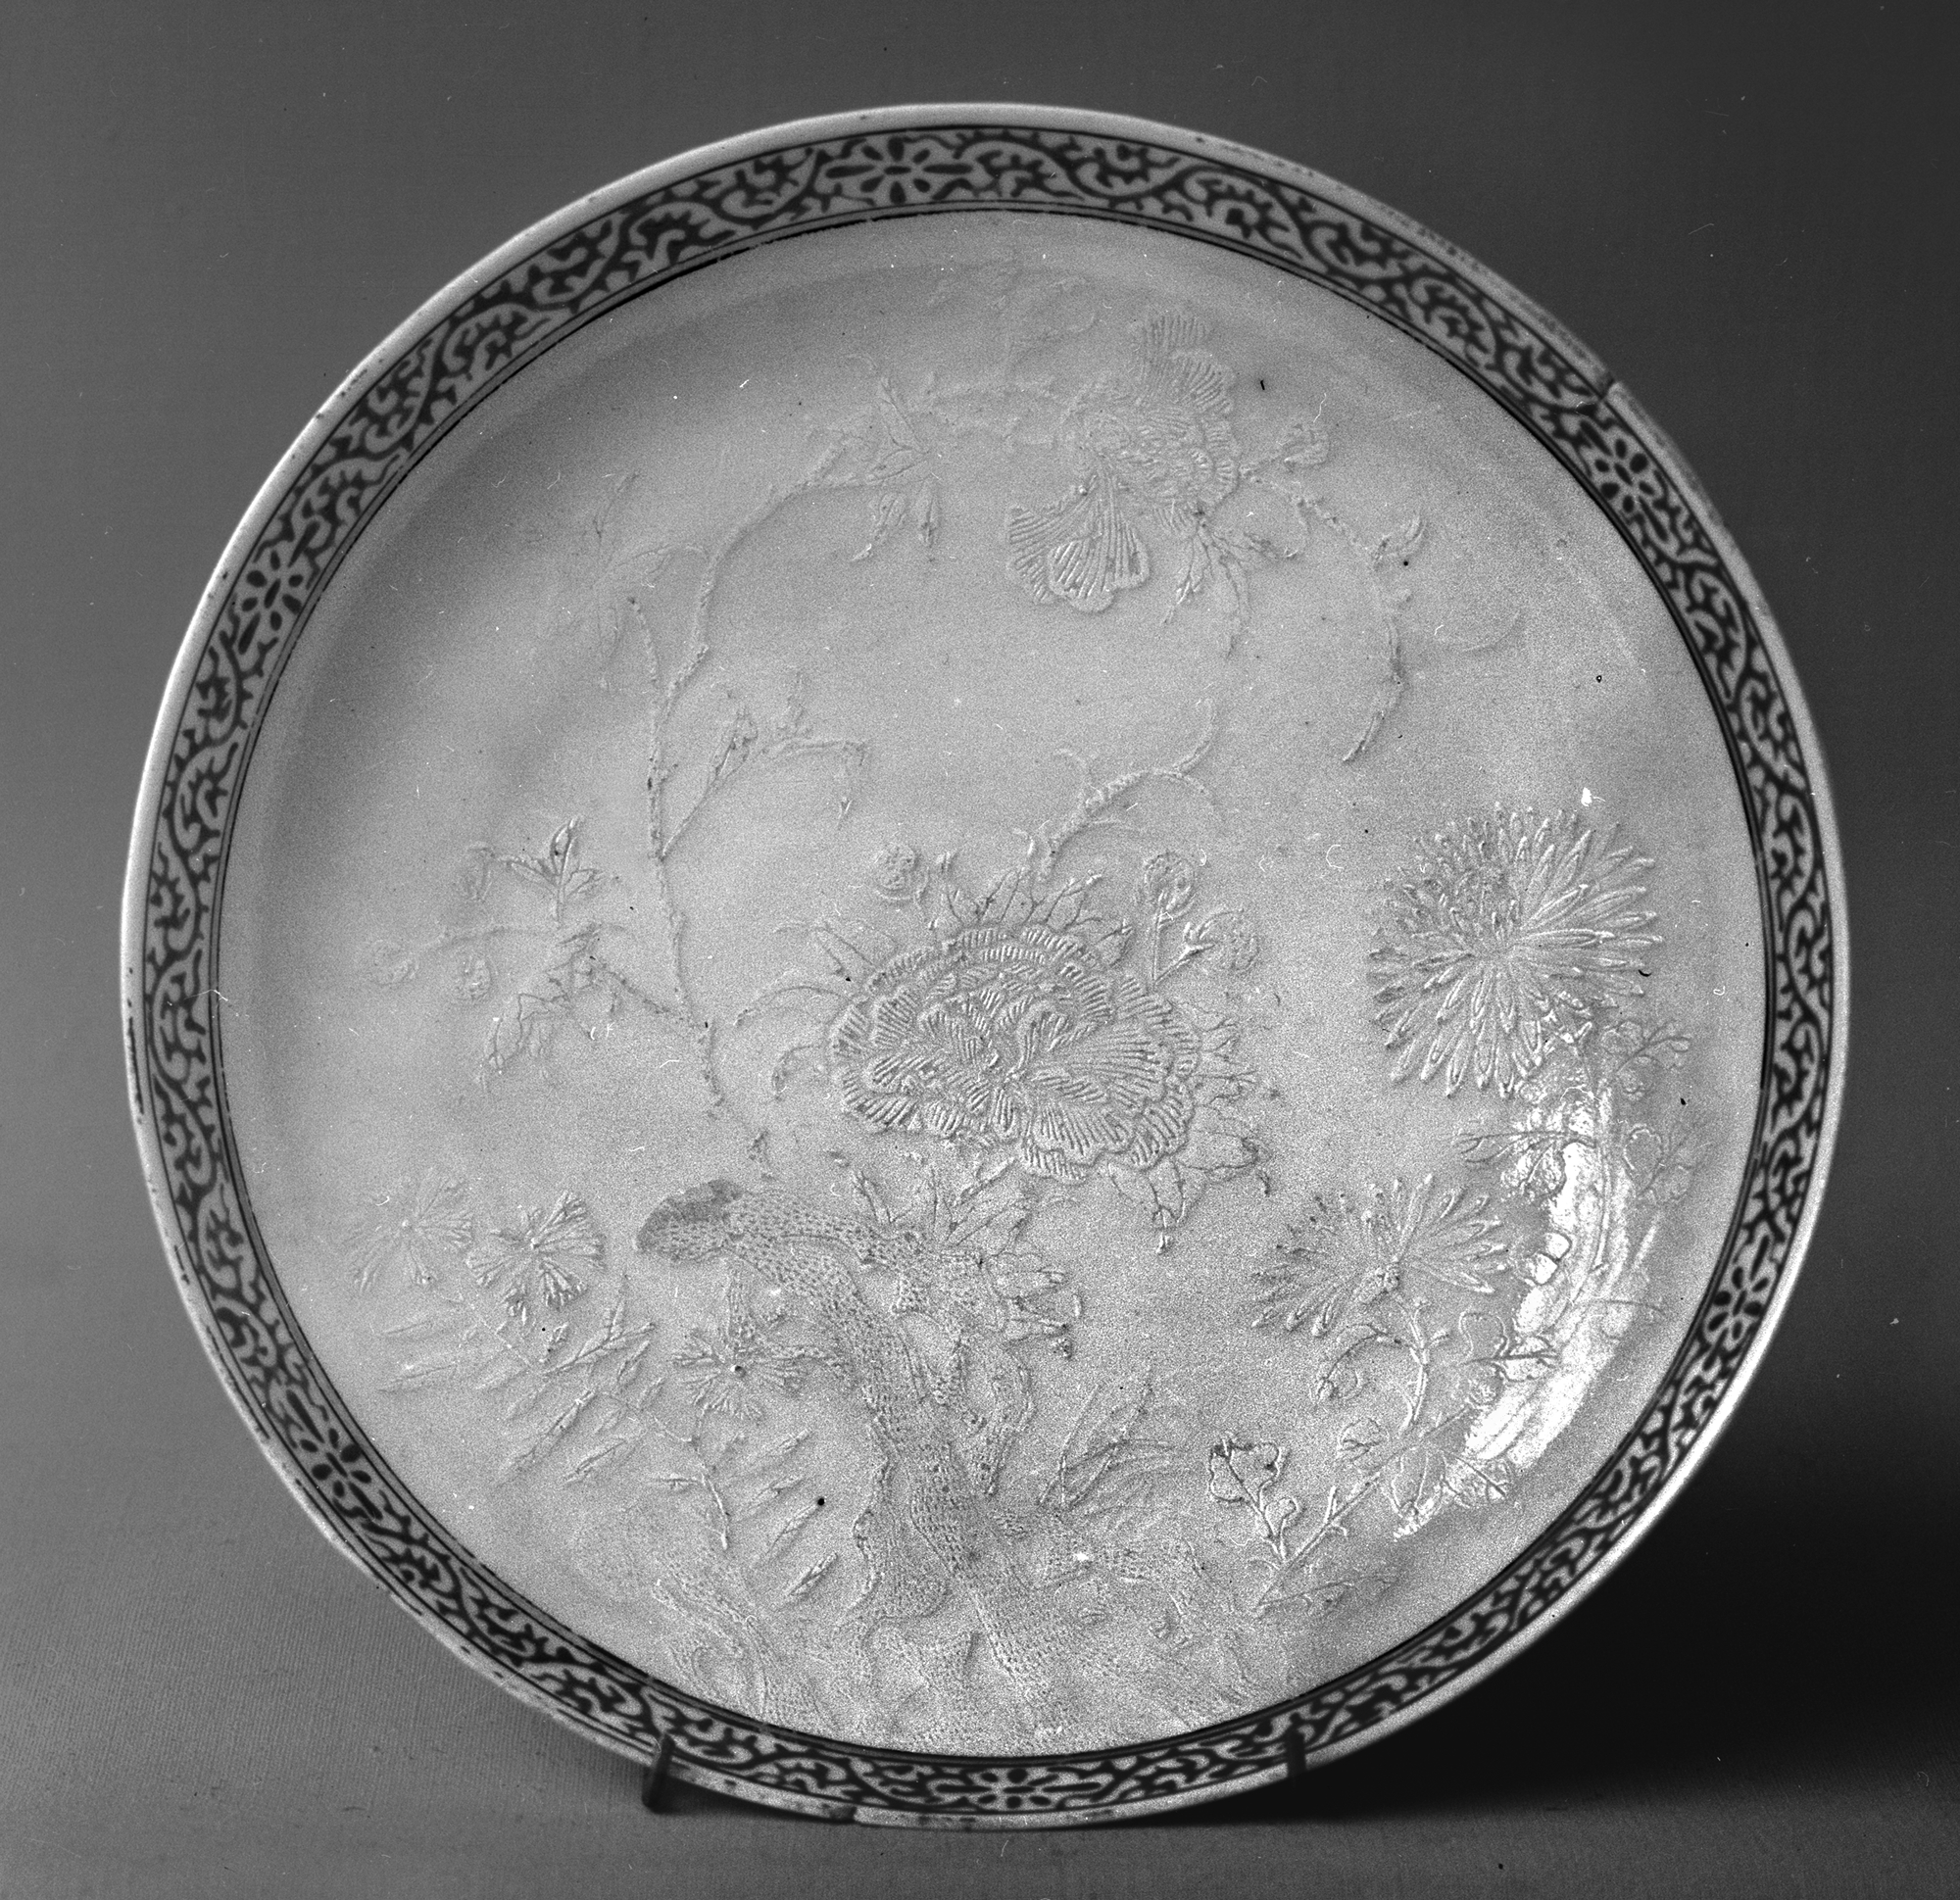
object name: saucer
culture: chinese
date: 1767-1800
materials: enamel, porcelain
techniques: incising, overglaze, painting